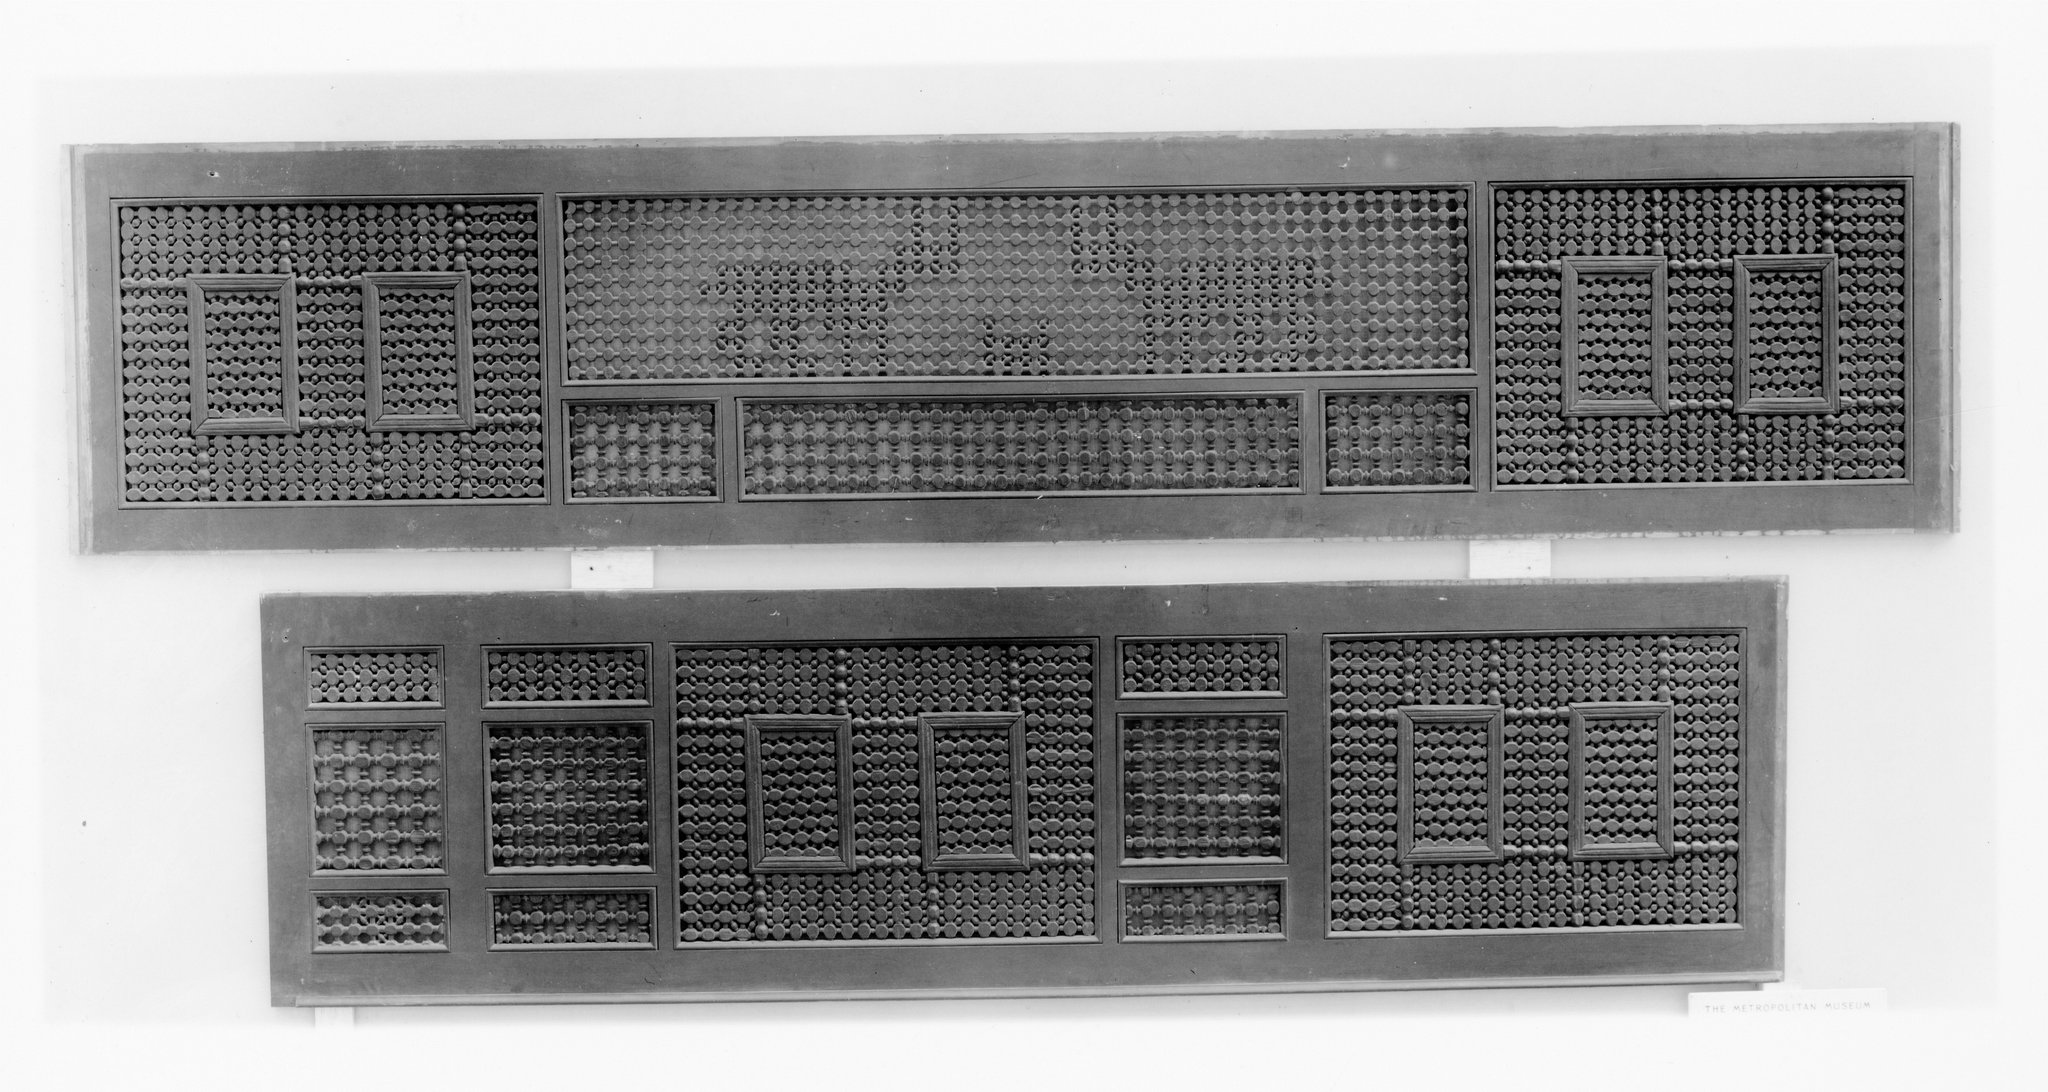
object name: screen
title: Mashrabiyya Screen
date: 1401-1600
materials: wood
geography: egypt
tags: screens